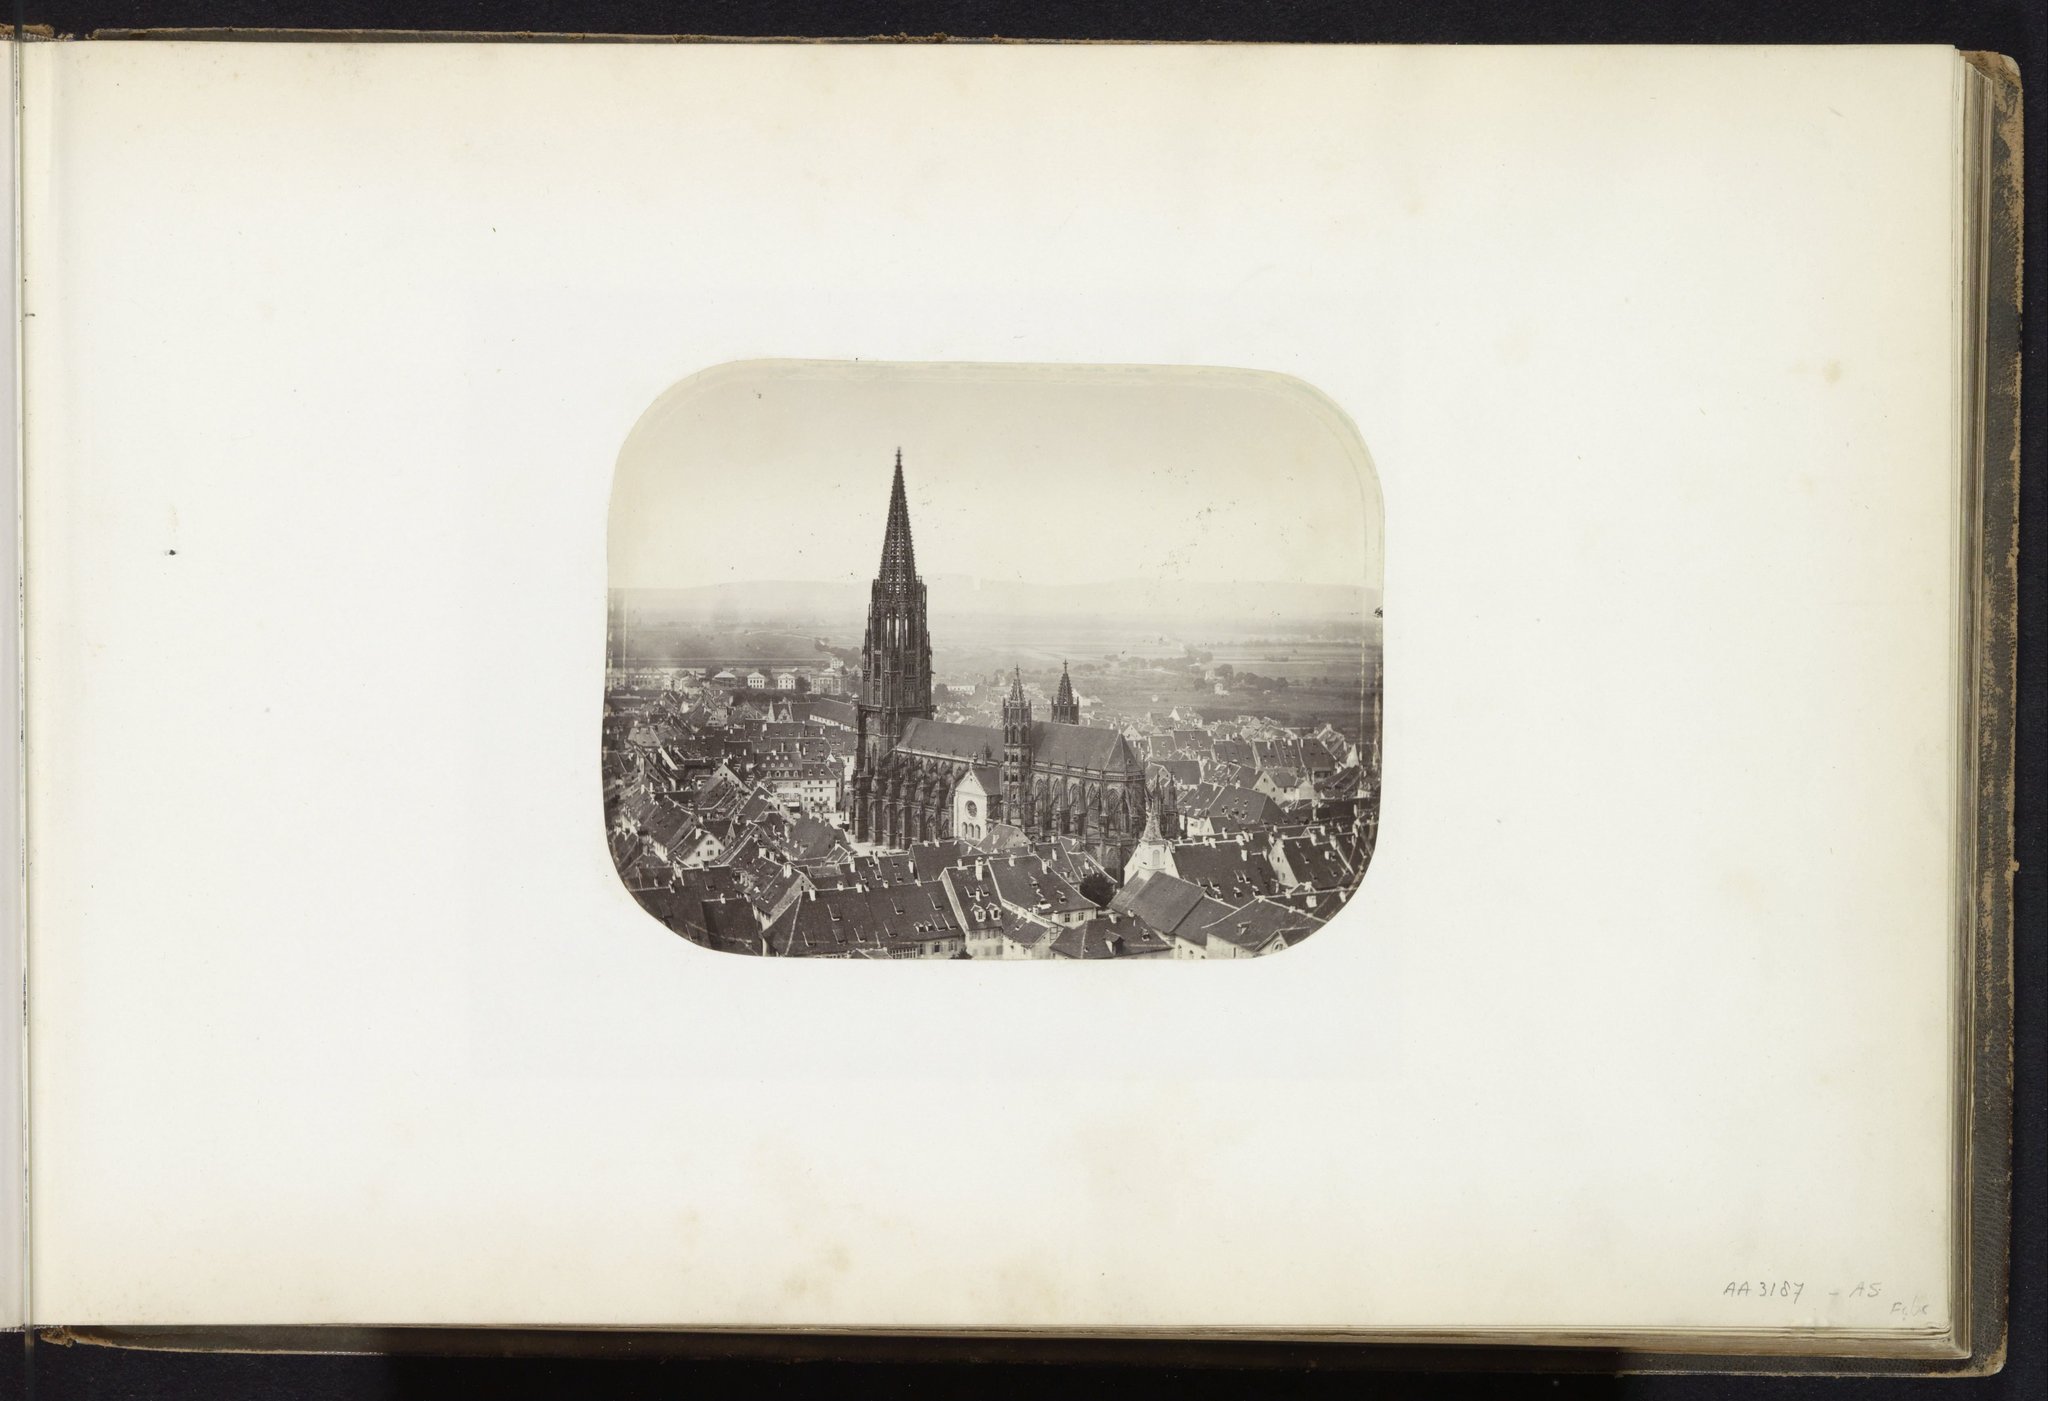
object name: photograph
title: Gezicht op de Munster van Freiburg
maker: Anonymous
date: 1865-1875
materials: photographic support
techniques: albumen print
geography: central europe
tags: church (exterior), parts of church exterior and annexes: spire, prospect of city, town panorama, silhouette of city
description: Onderdeel van Reisalbum met opnames van bezienswaardigheden in India, Duitsland, Zwitserland en Frankrijk.